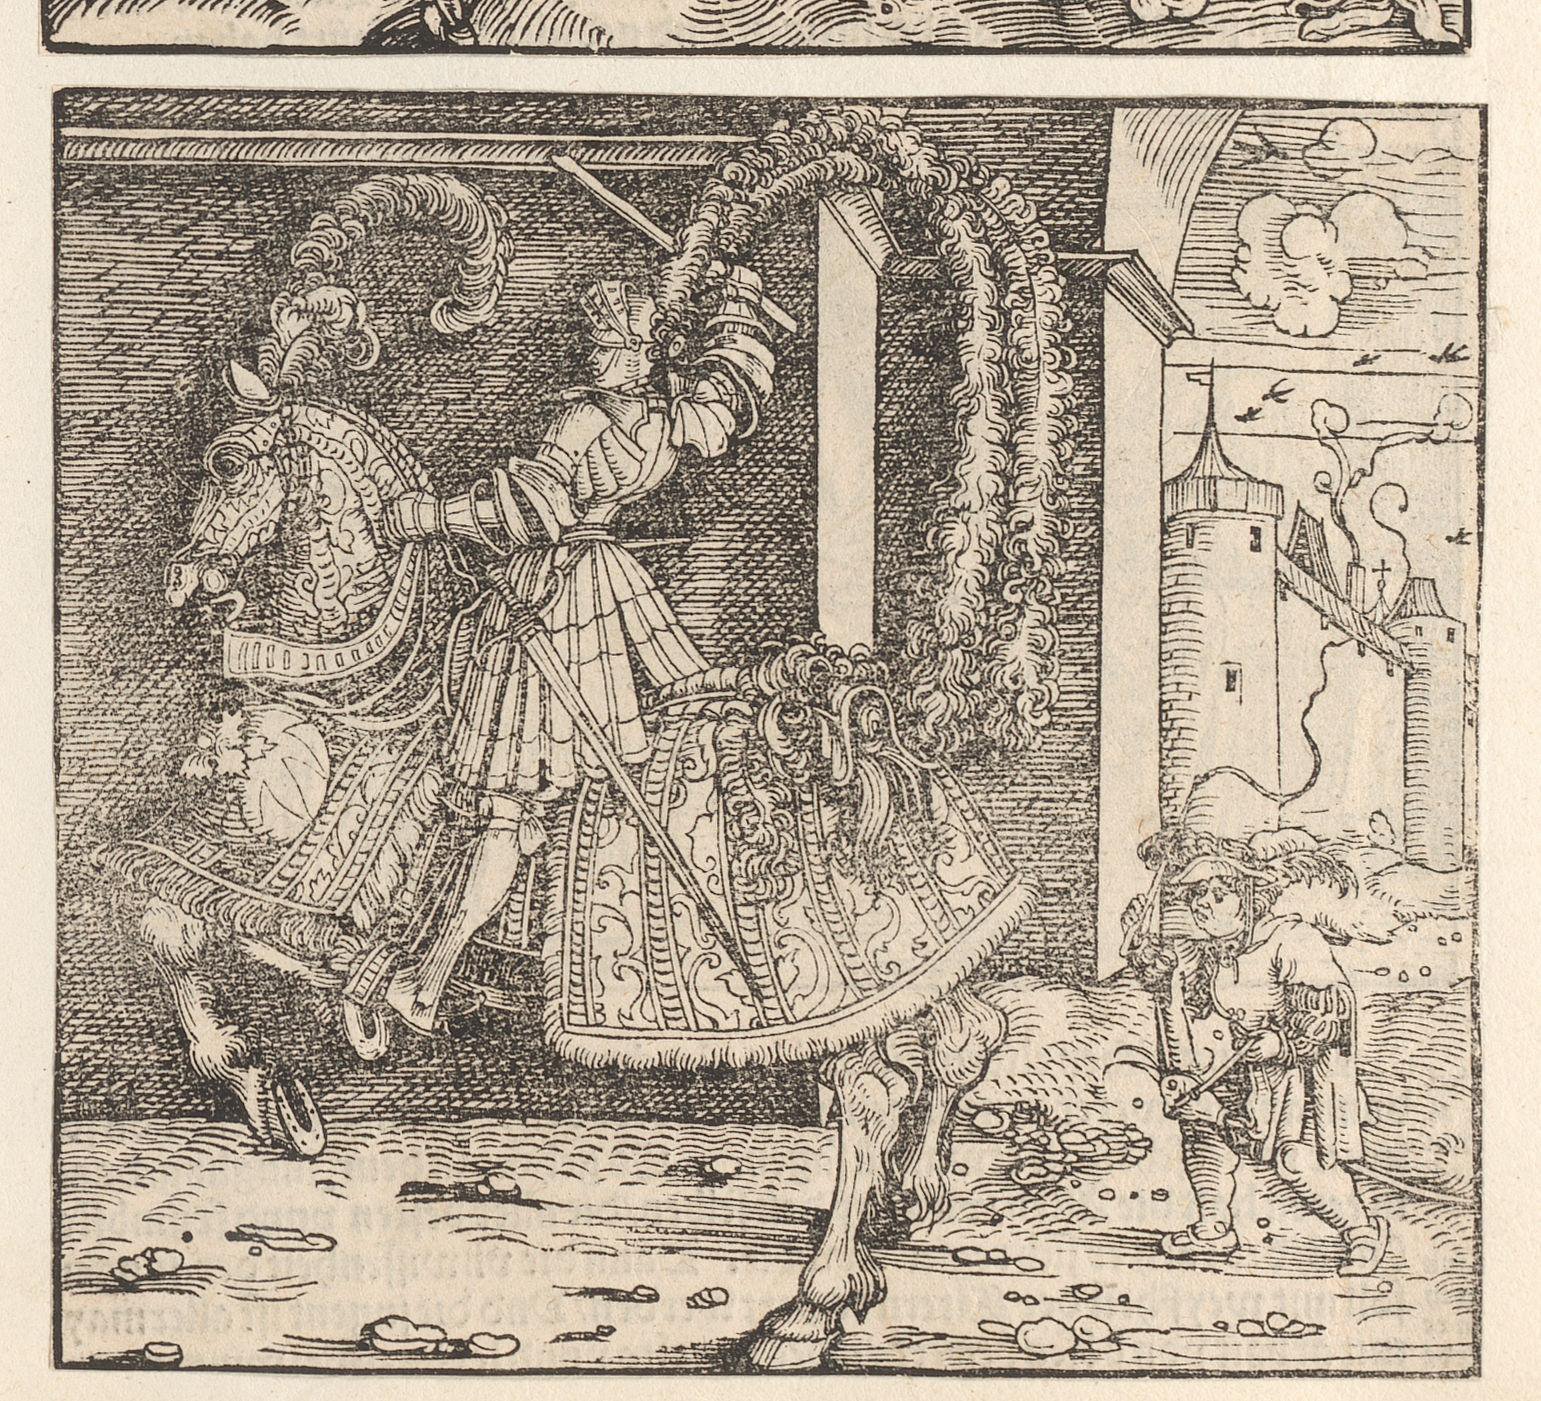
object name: book illustration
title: Ridder te paard gevolgd door kind met een stokpaard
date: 1514-1531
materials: paper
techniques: letterpress printing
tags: riding a horse, ass, or mule; rider, horseman, (playing with) toys ~ transport, knight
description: Deze prent is gebruikt in: Cicero, Marcus Tulius. Officia M.T.C. Ein Buch so Marcus Tullius Cicero der Römer zu seynem (...). [Vertaald uit het Latijn door] Johann von Schwarzenberg. Augsburg: Heinrich Steiner, 1531.